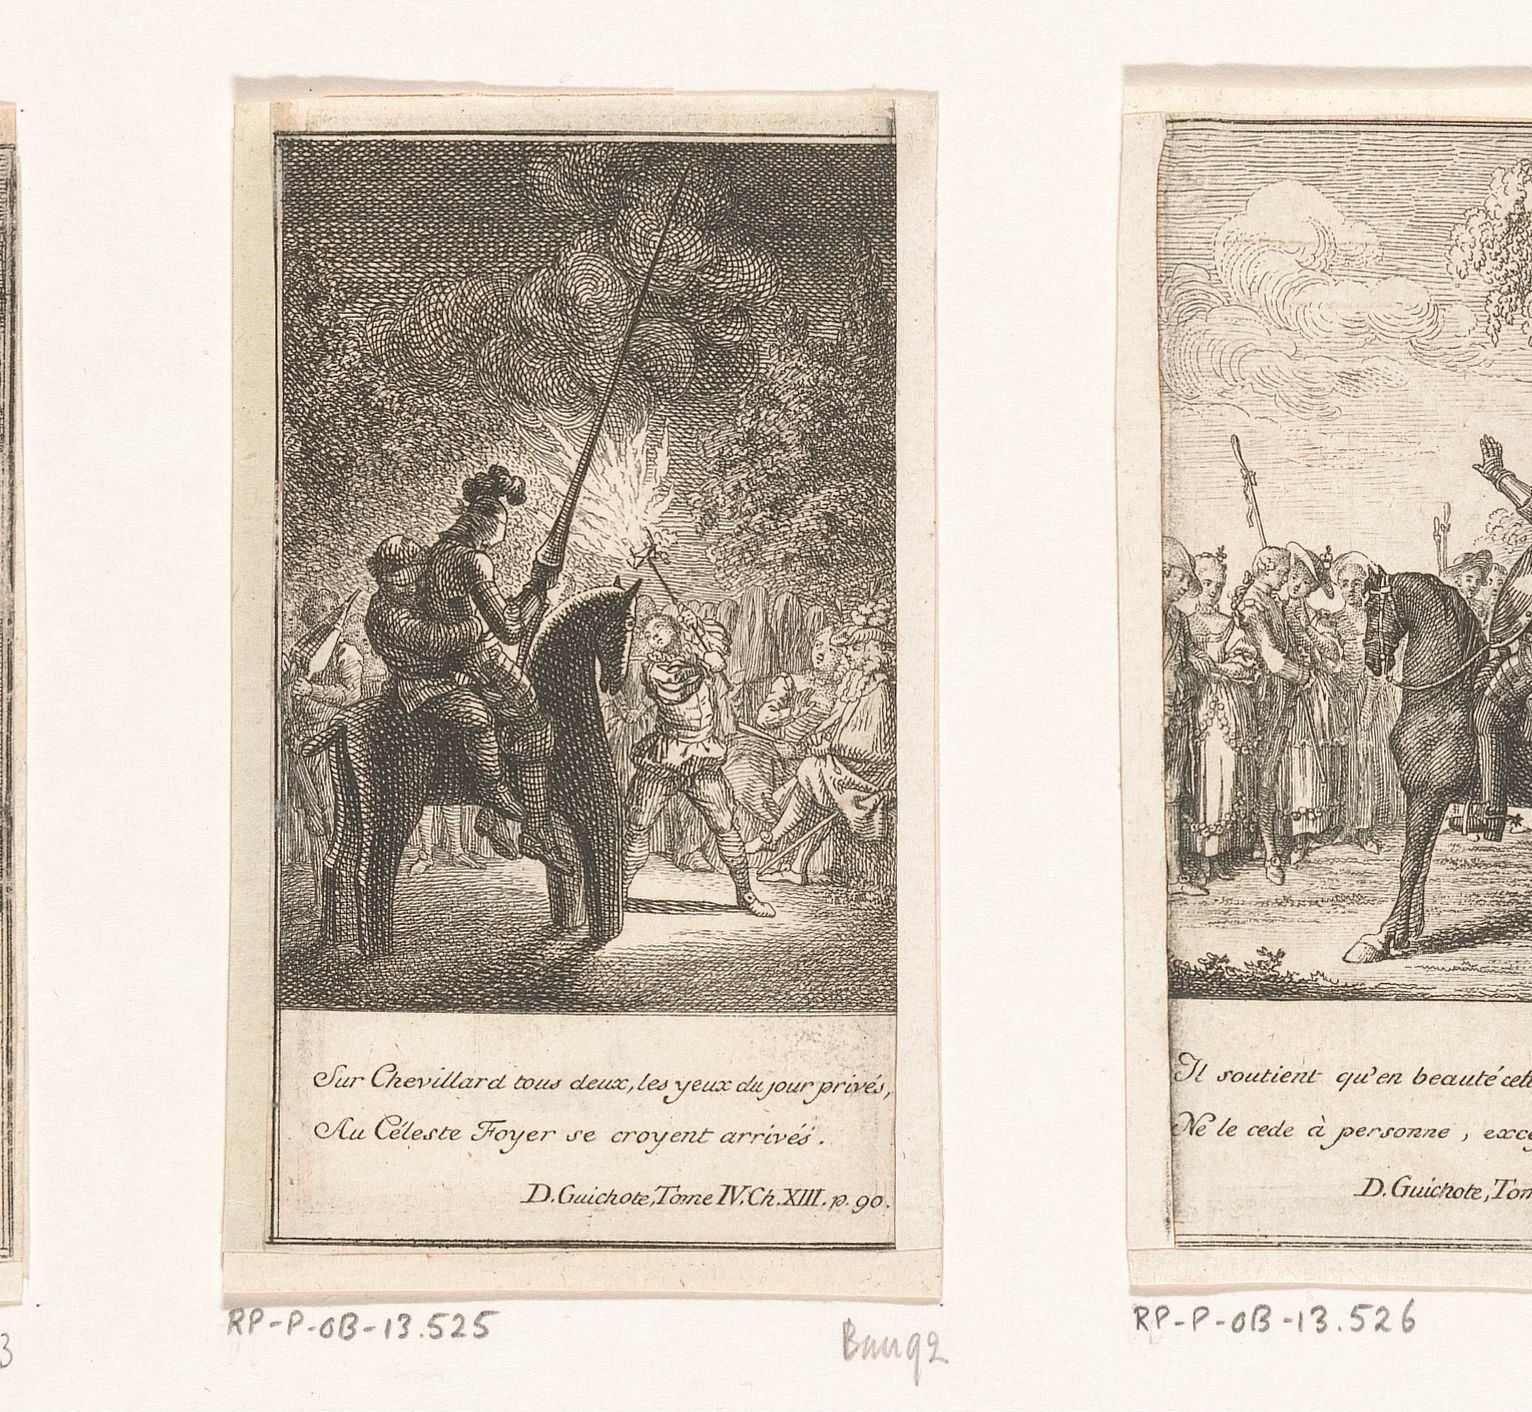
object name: print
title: Don Quichot en Sancho Panza op Clavileño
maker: daniel nikolaus chodowiecki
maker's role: draughtsman, print maker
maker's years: 1726-1801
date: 1770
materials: paper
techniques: etching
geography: berlin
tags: don quixote, sancho panza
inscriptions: collector's mark: Lugt 2228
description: Om de reus Malambruno te bereiken moeten Don Quichot en Sancho Panza door de lucht reizen op het magische houten paard Clavileño. In deze scène zitten Don Quichot en Sancho Panza geblinddoekt op Clavileño. Een man met een blaasbalg en een man met een fakkel maken de ridder en zijn knecht wijs dat dat ze door de lucht vliegen. Rechts kijken de hertog en hertogin toe.